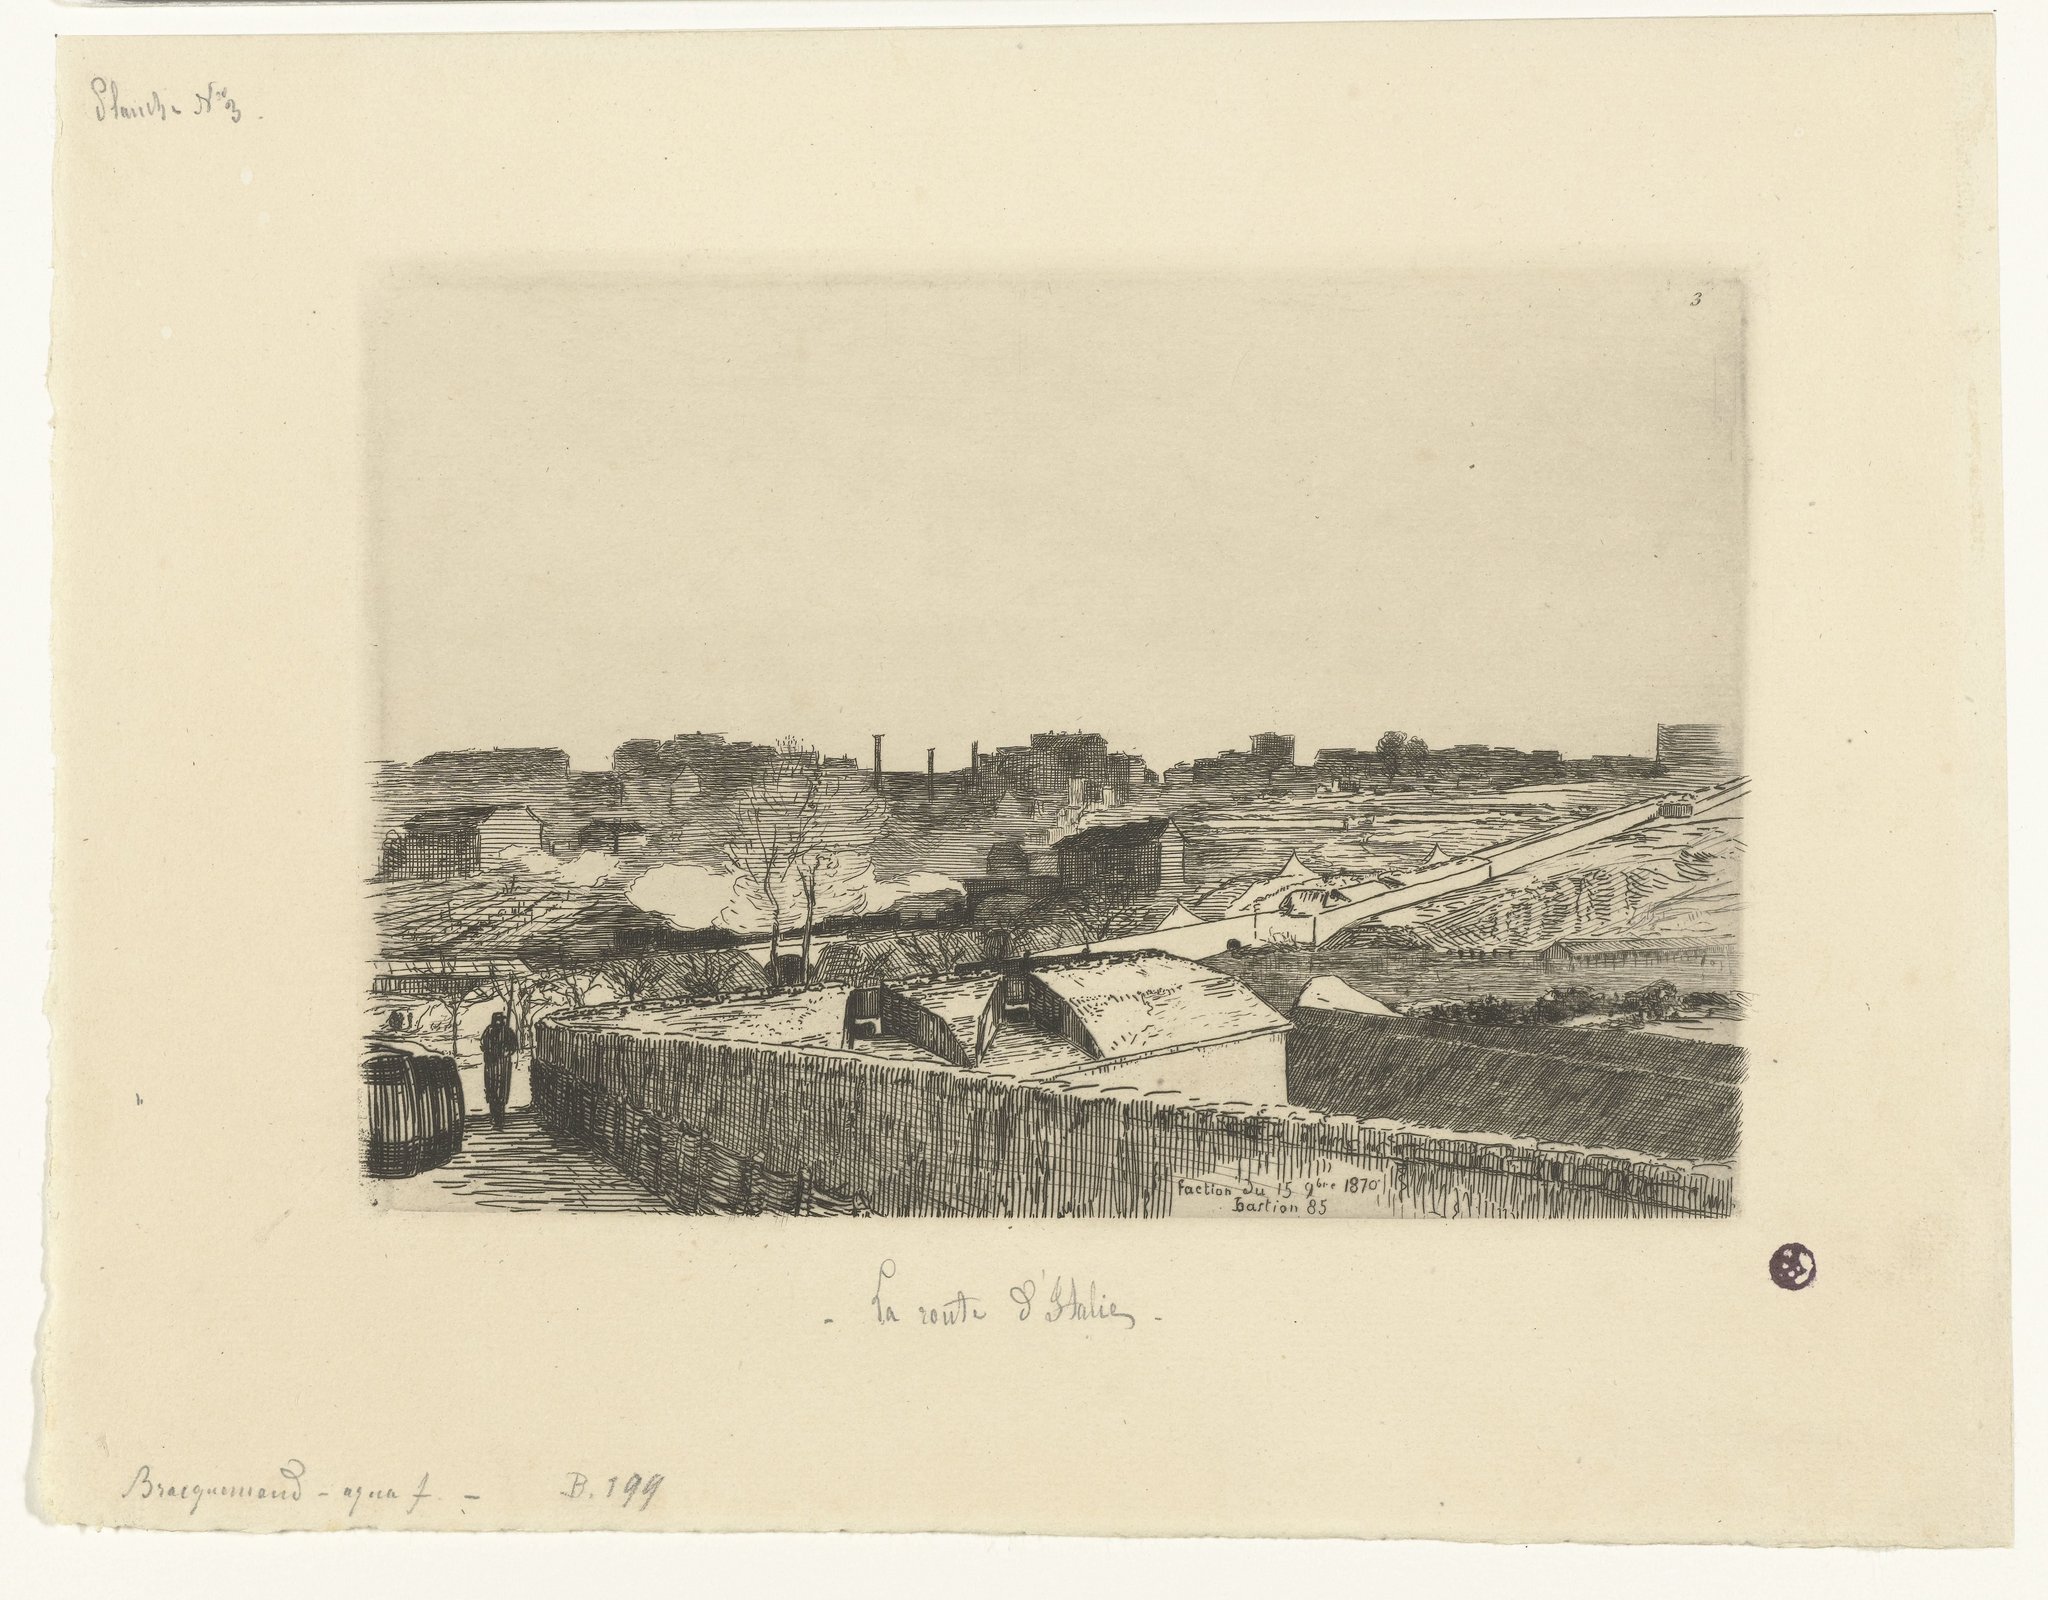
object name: print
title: Militaire wacht bij bastion 85 aan kant van Route d'Italie in Parijs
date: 1870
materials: paper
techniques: etching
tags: fortifications, military engineering, paris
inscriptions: collector's mark: Lugt 76, collector's mark: Lugt 2228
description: Ets gebruikt voor: Siège de Paris en 1870, Roquette (uitgever), 1874. Verschenen in een oplage van honderd exemplaren maar het is onduidelijk welke staat gebruikt werd voor de publicatie (Beraldi 1885, nr. 199).